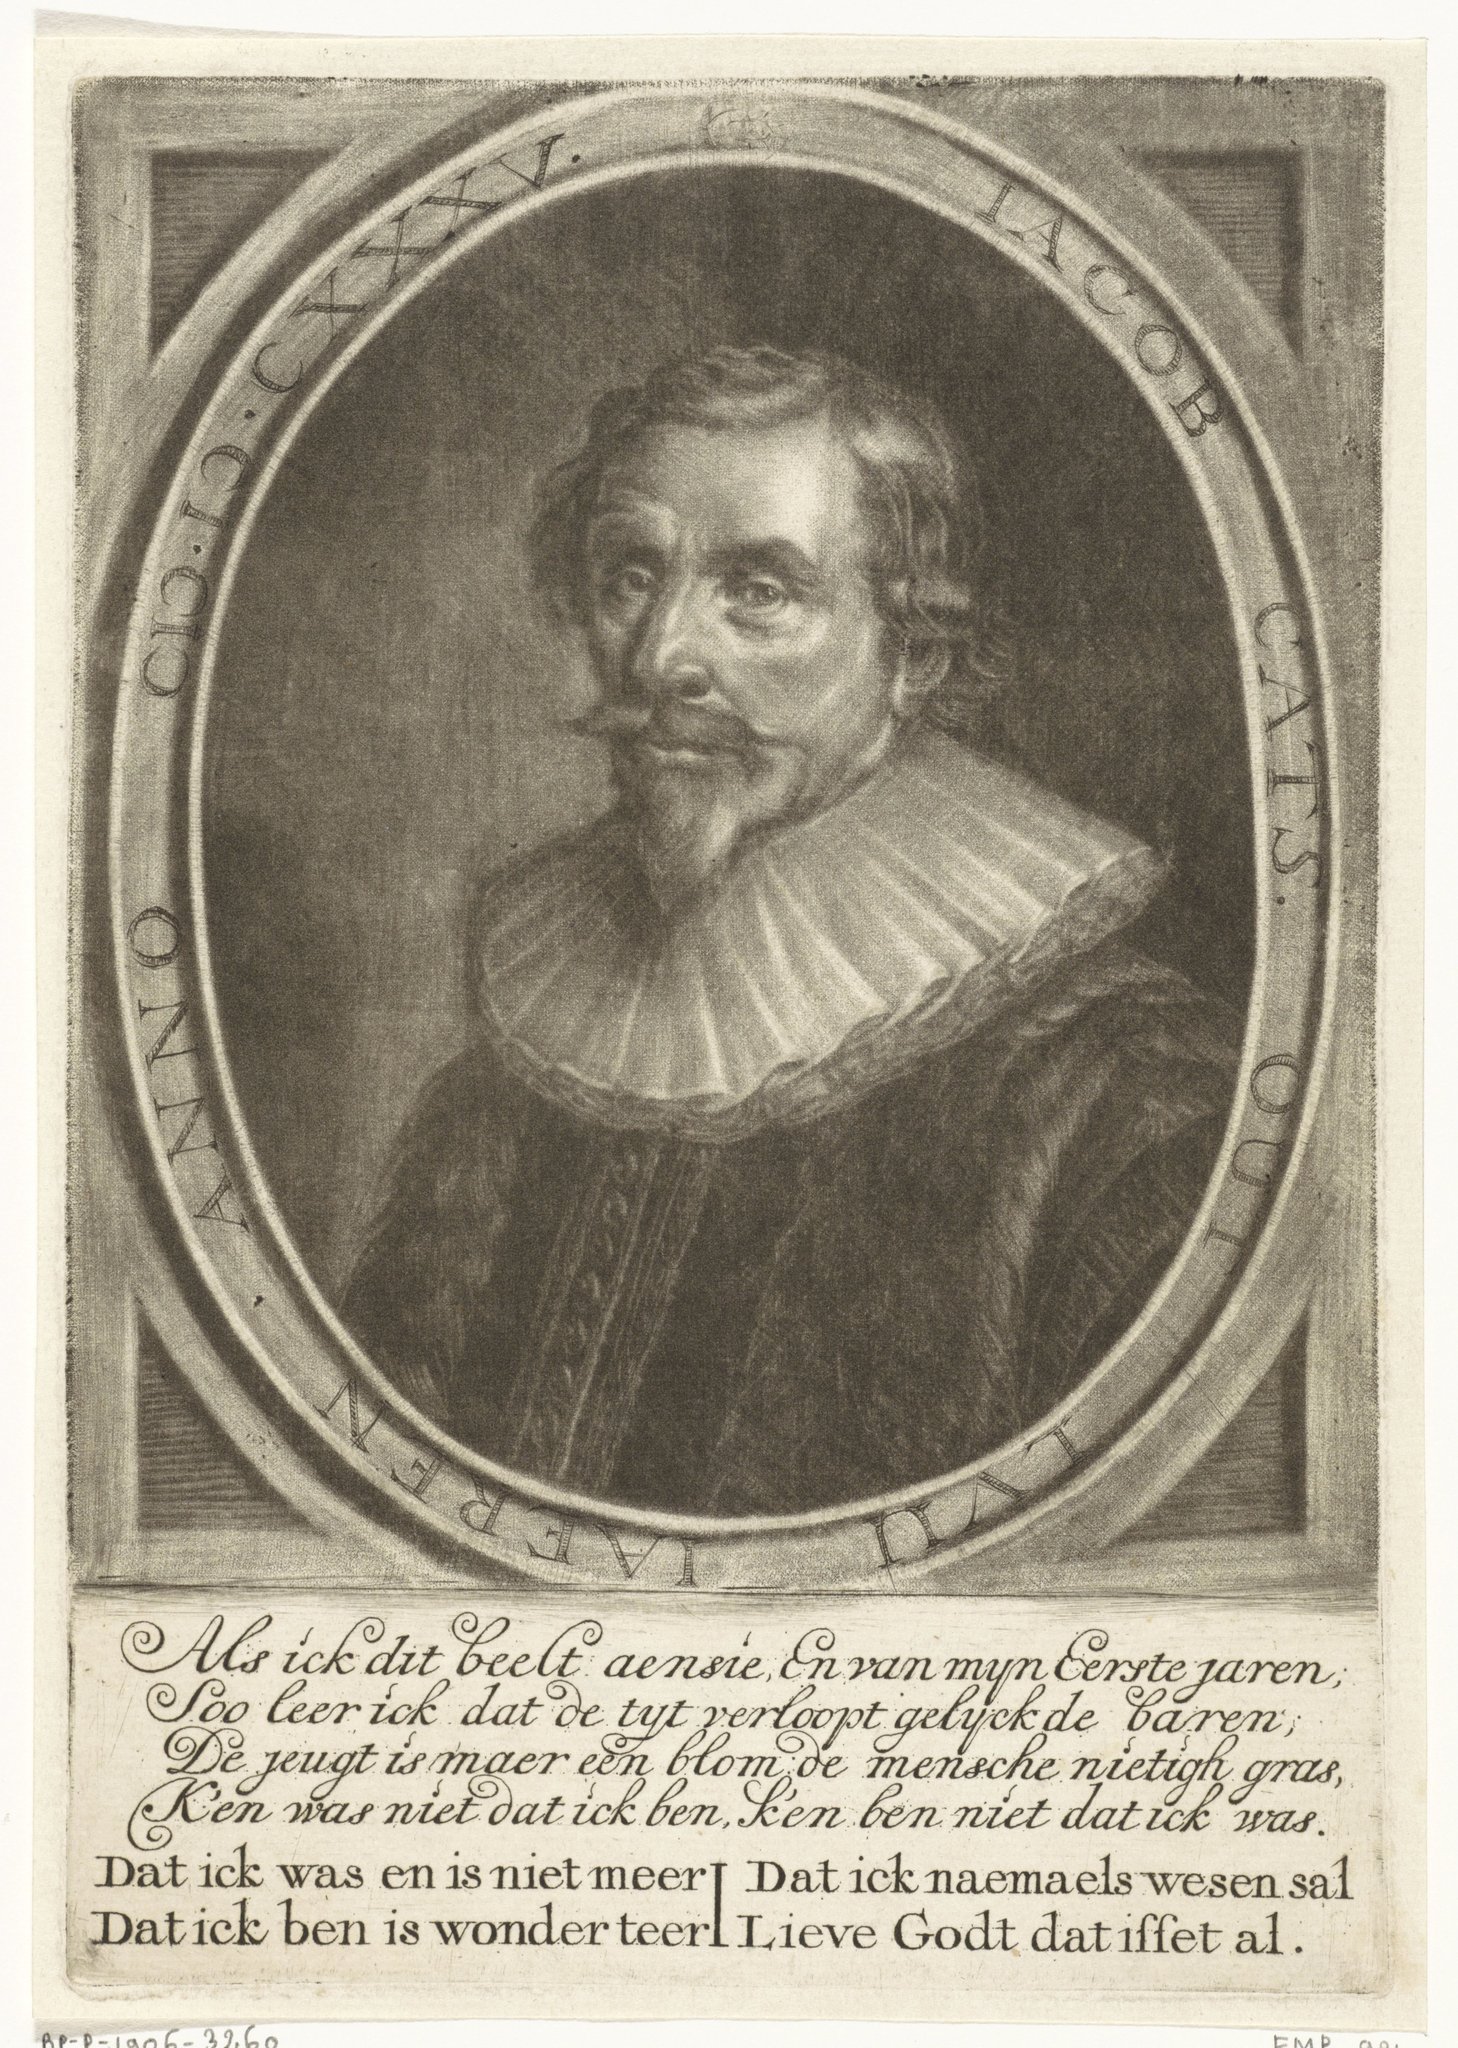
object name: print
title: Portret van Jacob Cats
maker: johannes de groot (ii)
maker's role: painter, print maker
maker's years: 1688-1796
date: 1698-1776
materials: paper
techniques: engraving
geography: northern netherlands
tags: the hague, jacob cats (1577-1660), historical persons, portrait of a writer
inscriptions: collector's mark: Lugt 2228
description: De pensionaris van Dordrecht en dichter Jacob Cats op 57-jarige leeftijd. Hij draagt een plooikraag en een toga. In de marge twee Nederlandse verzen, mogelijk van Jacob Cats.